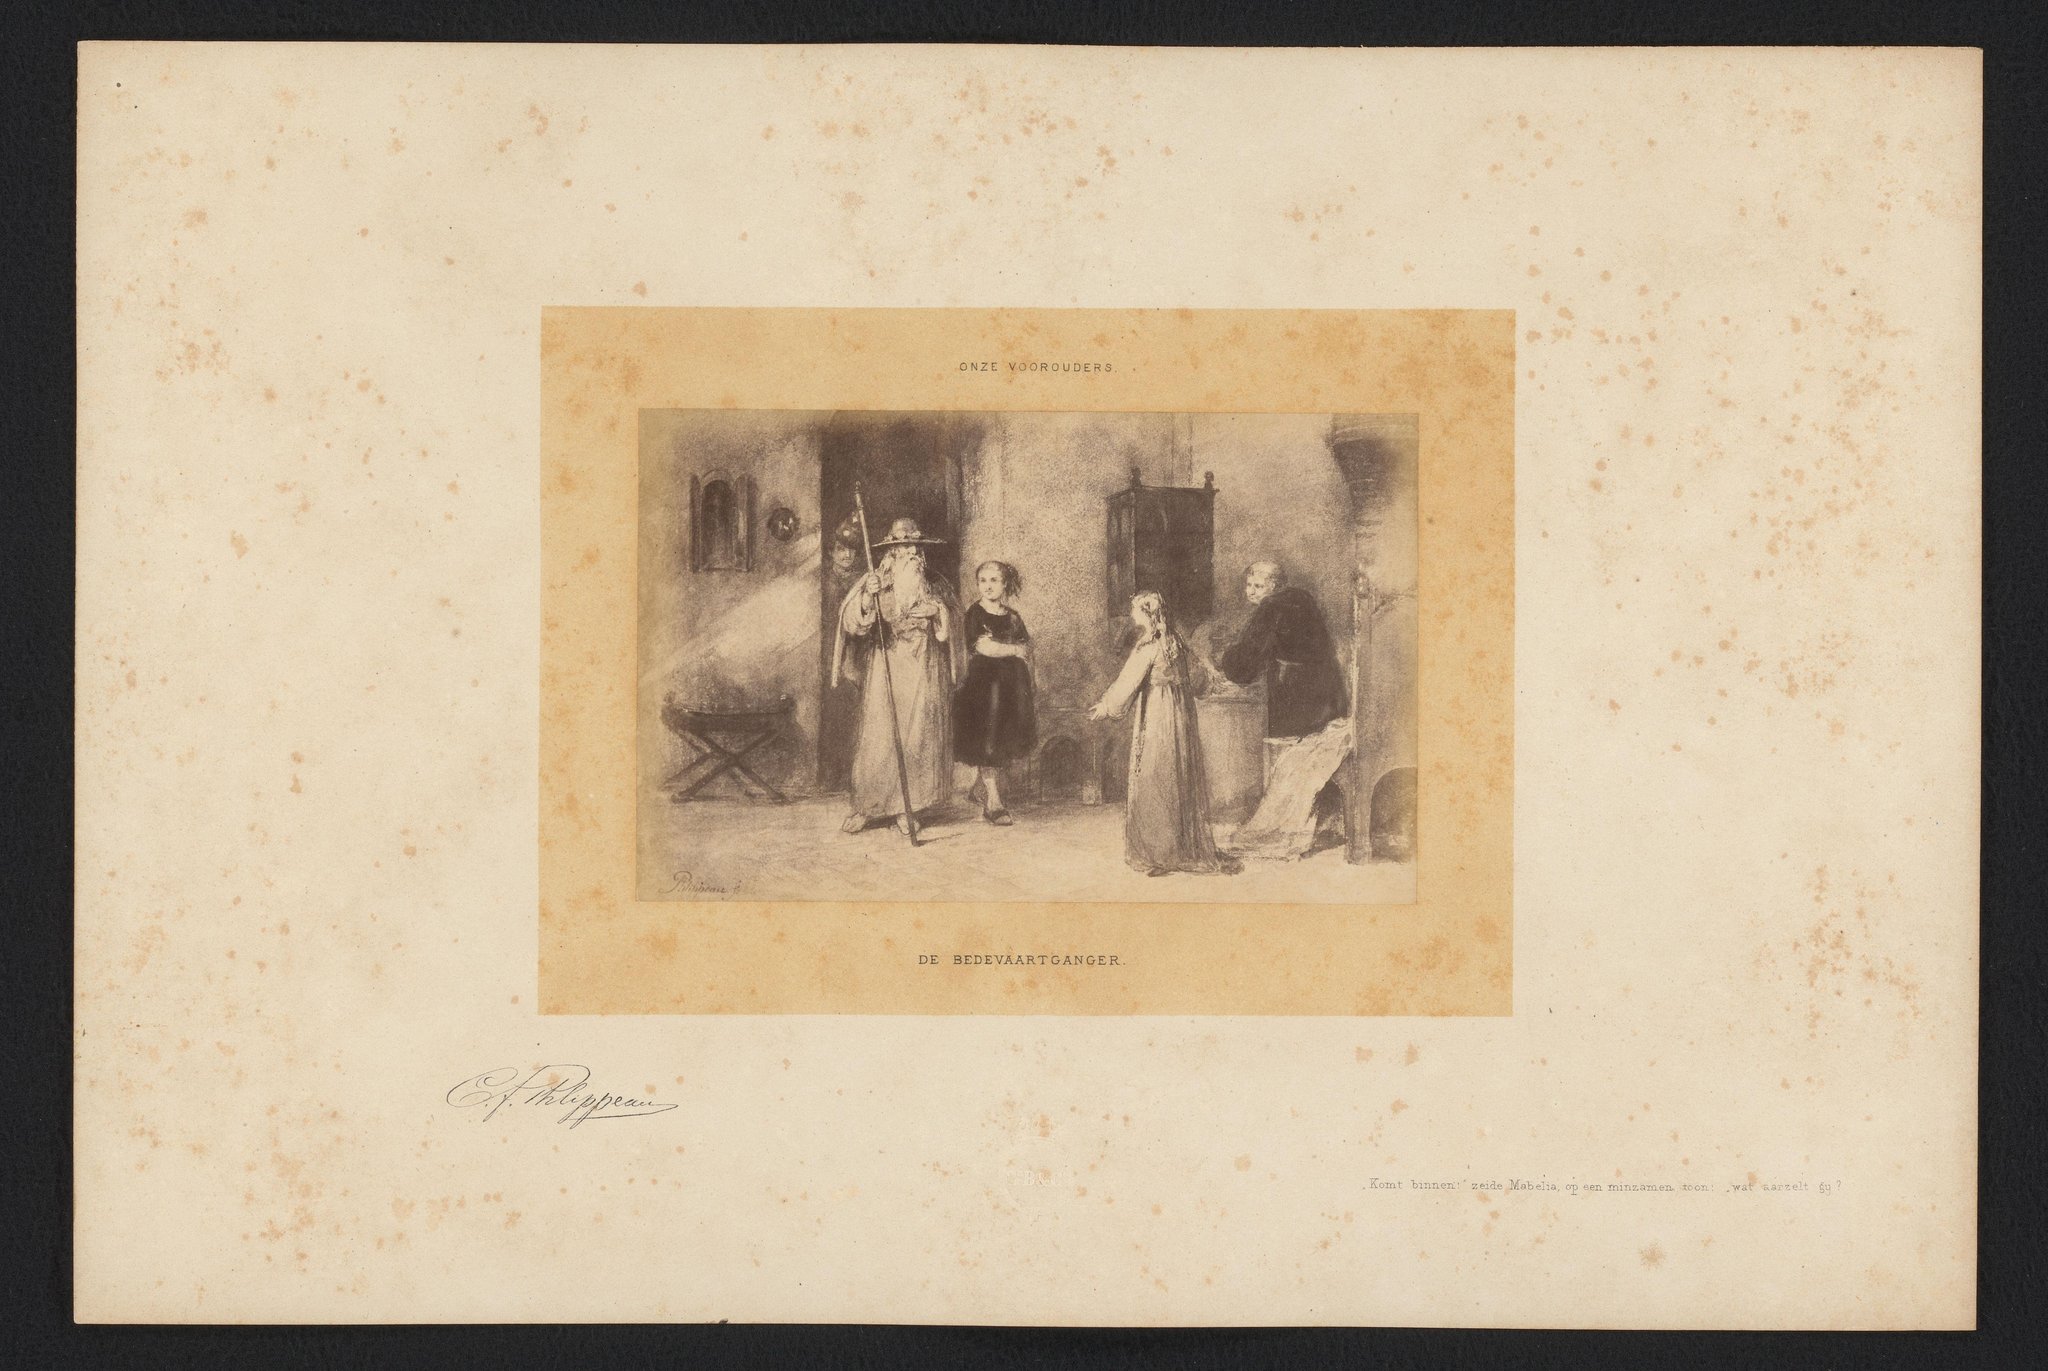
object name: photograph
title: Fotoreproductie van een tekening van een pelgrim in een interieur door Karel Frans Phlippeau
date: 1865-1870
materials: cardboard, paper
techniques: albumen print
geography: haarlem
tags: pilgrim(s), interior of the house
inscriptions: inscription: ‘"Komt binnen!" zeide (...) "wat aarzelt gij?"’, check stamp: ‘Ch. B & C.’, signature: ‘C.F. Phlippeau’